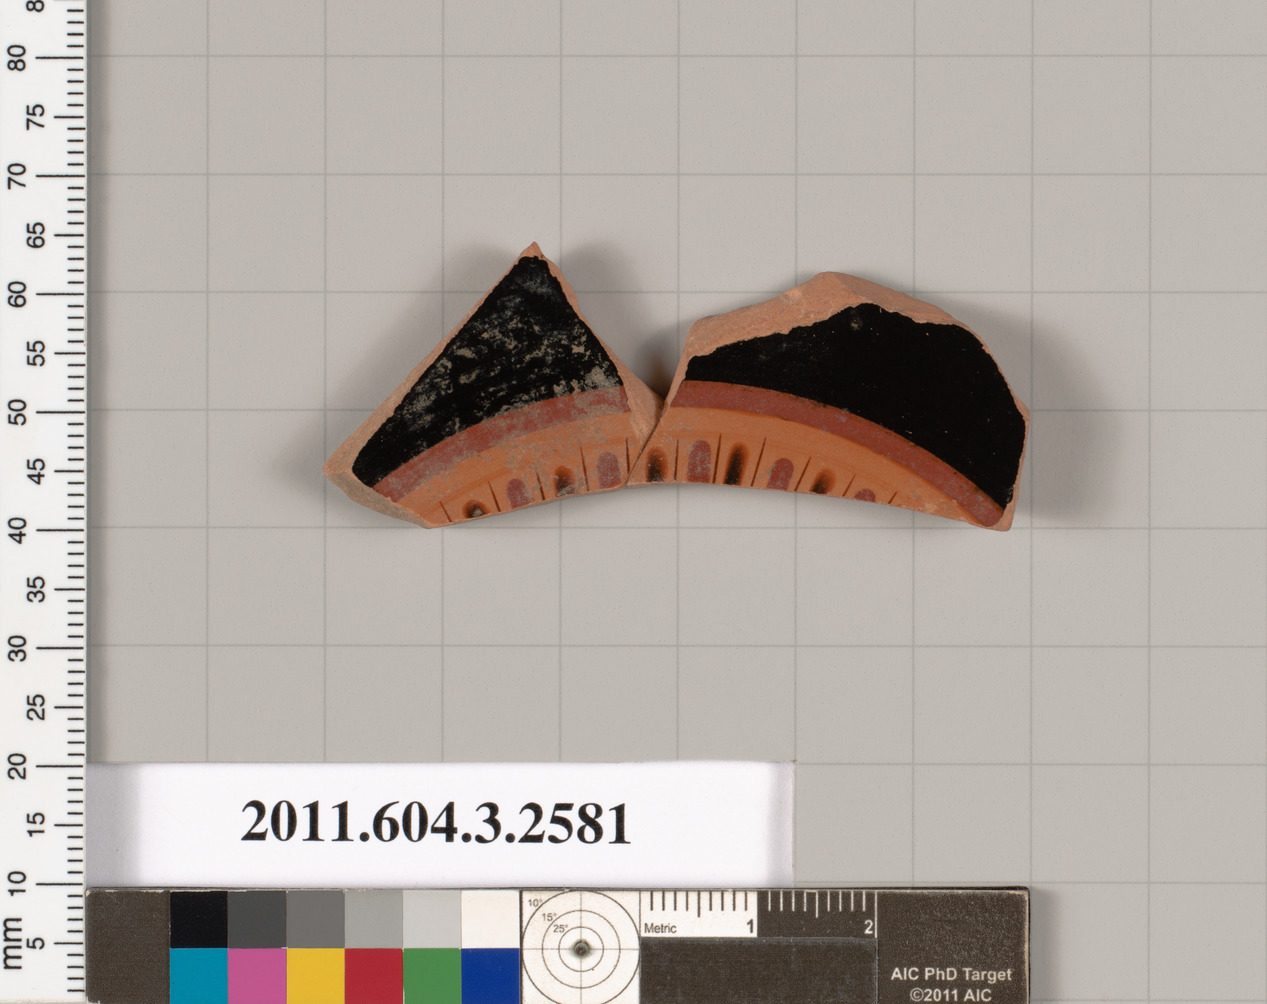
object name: kylix fragment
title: Terracotta fragment of a Little Master cup (drinking cup)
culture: greek, attic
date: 550-530 BCE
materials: terracotta